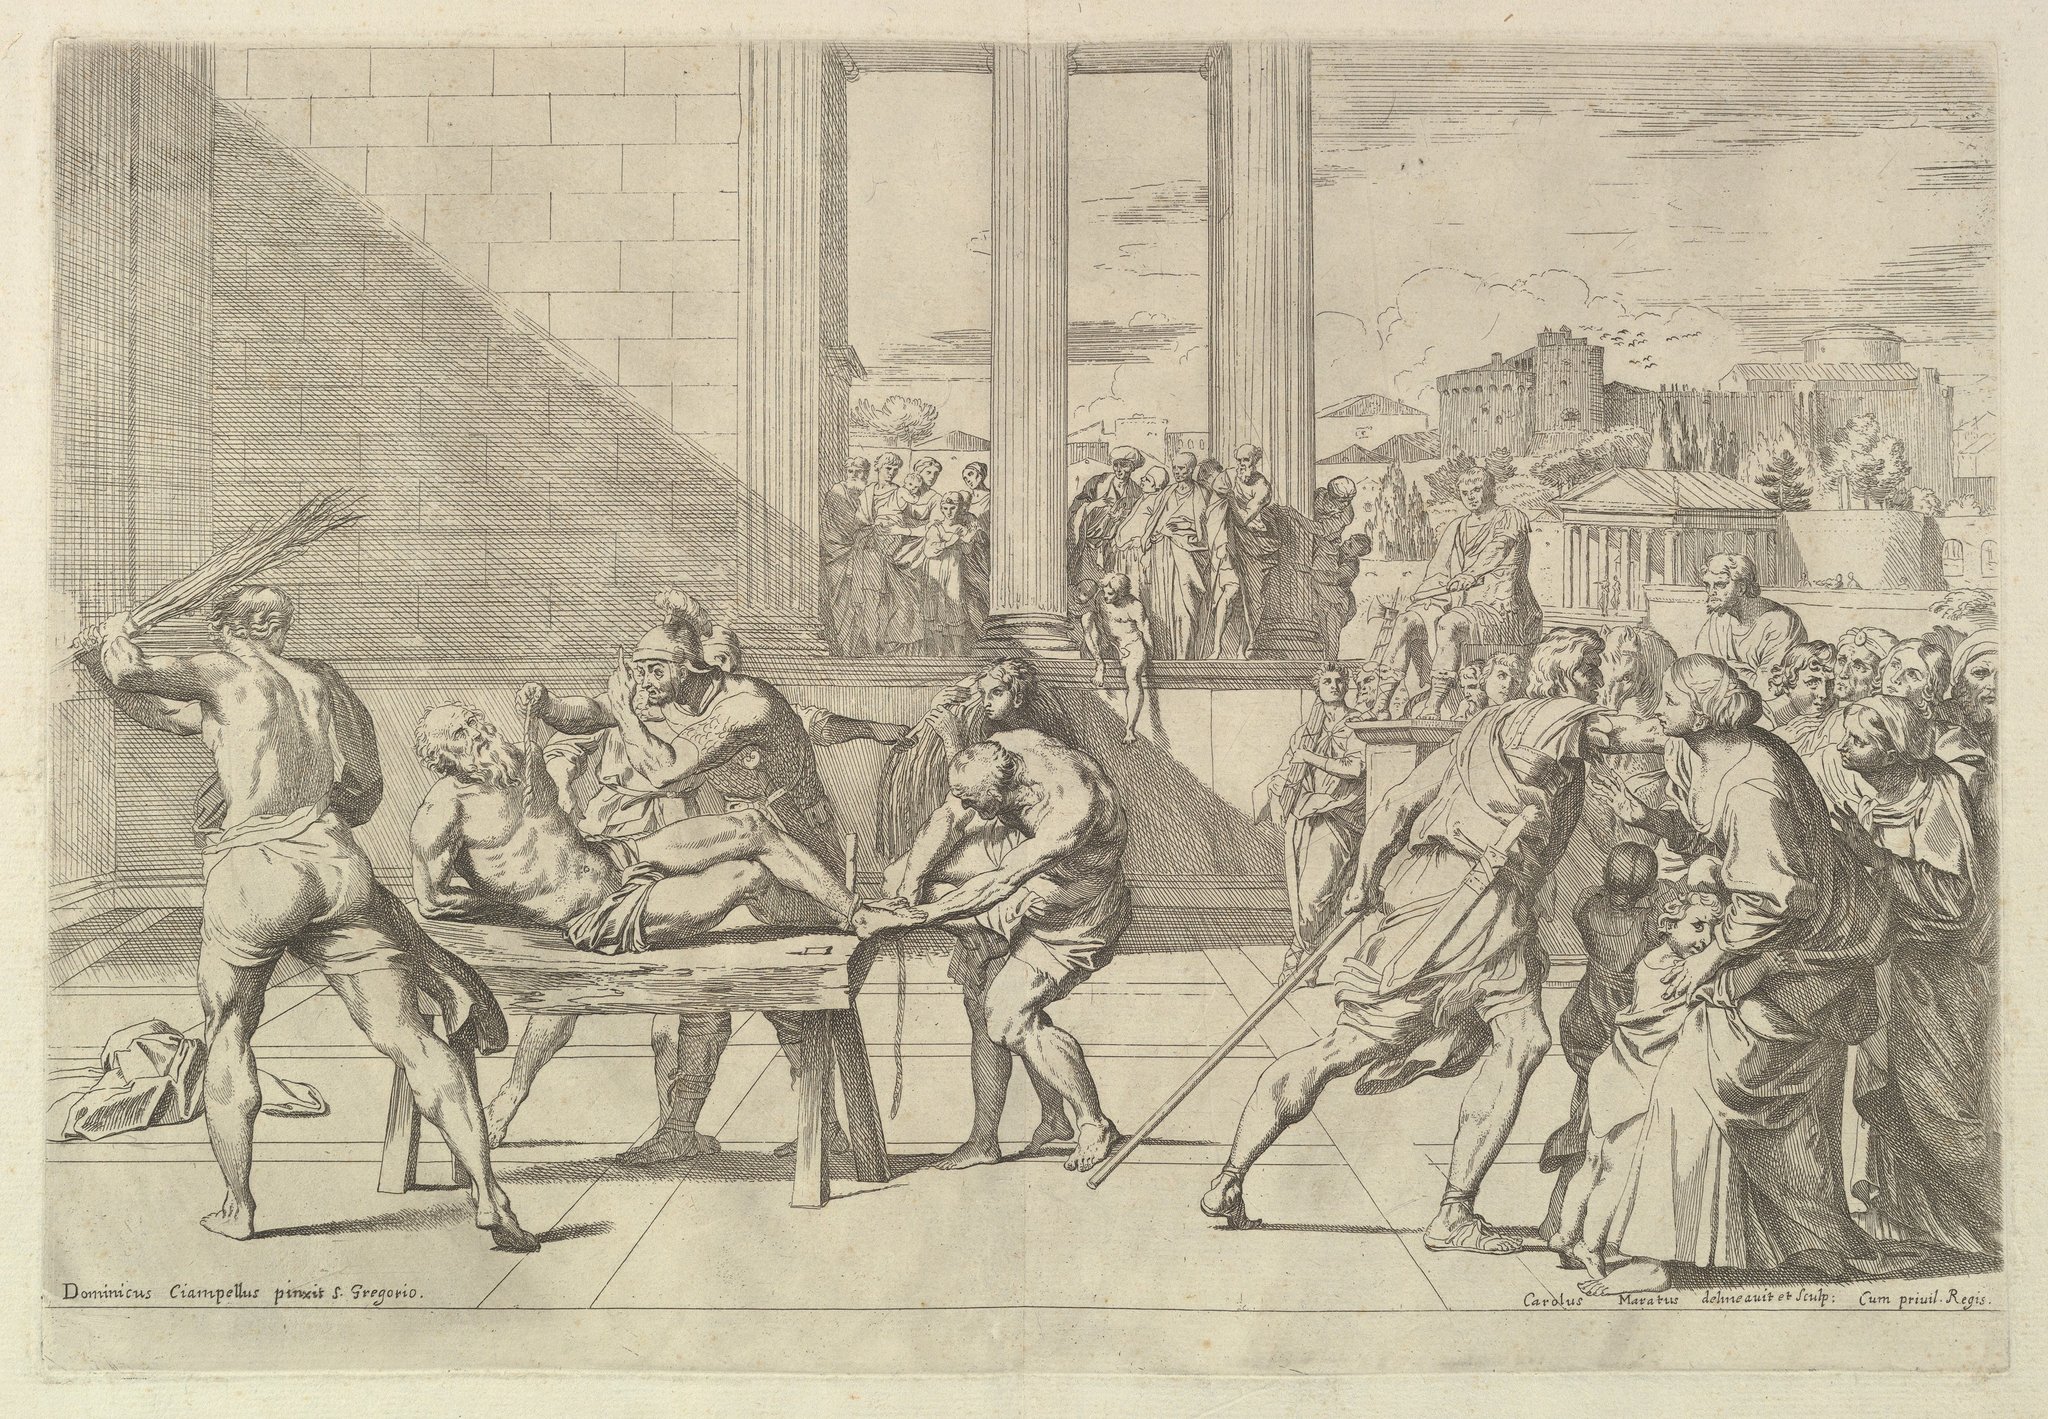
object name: print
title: Martyrdom of Saint Andrew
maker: carlo maratti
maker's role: artist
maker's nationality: italian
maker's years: 1625-1713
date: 1645-1660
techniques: etching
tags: soldiers,suffering,saints